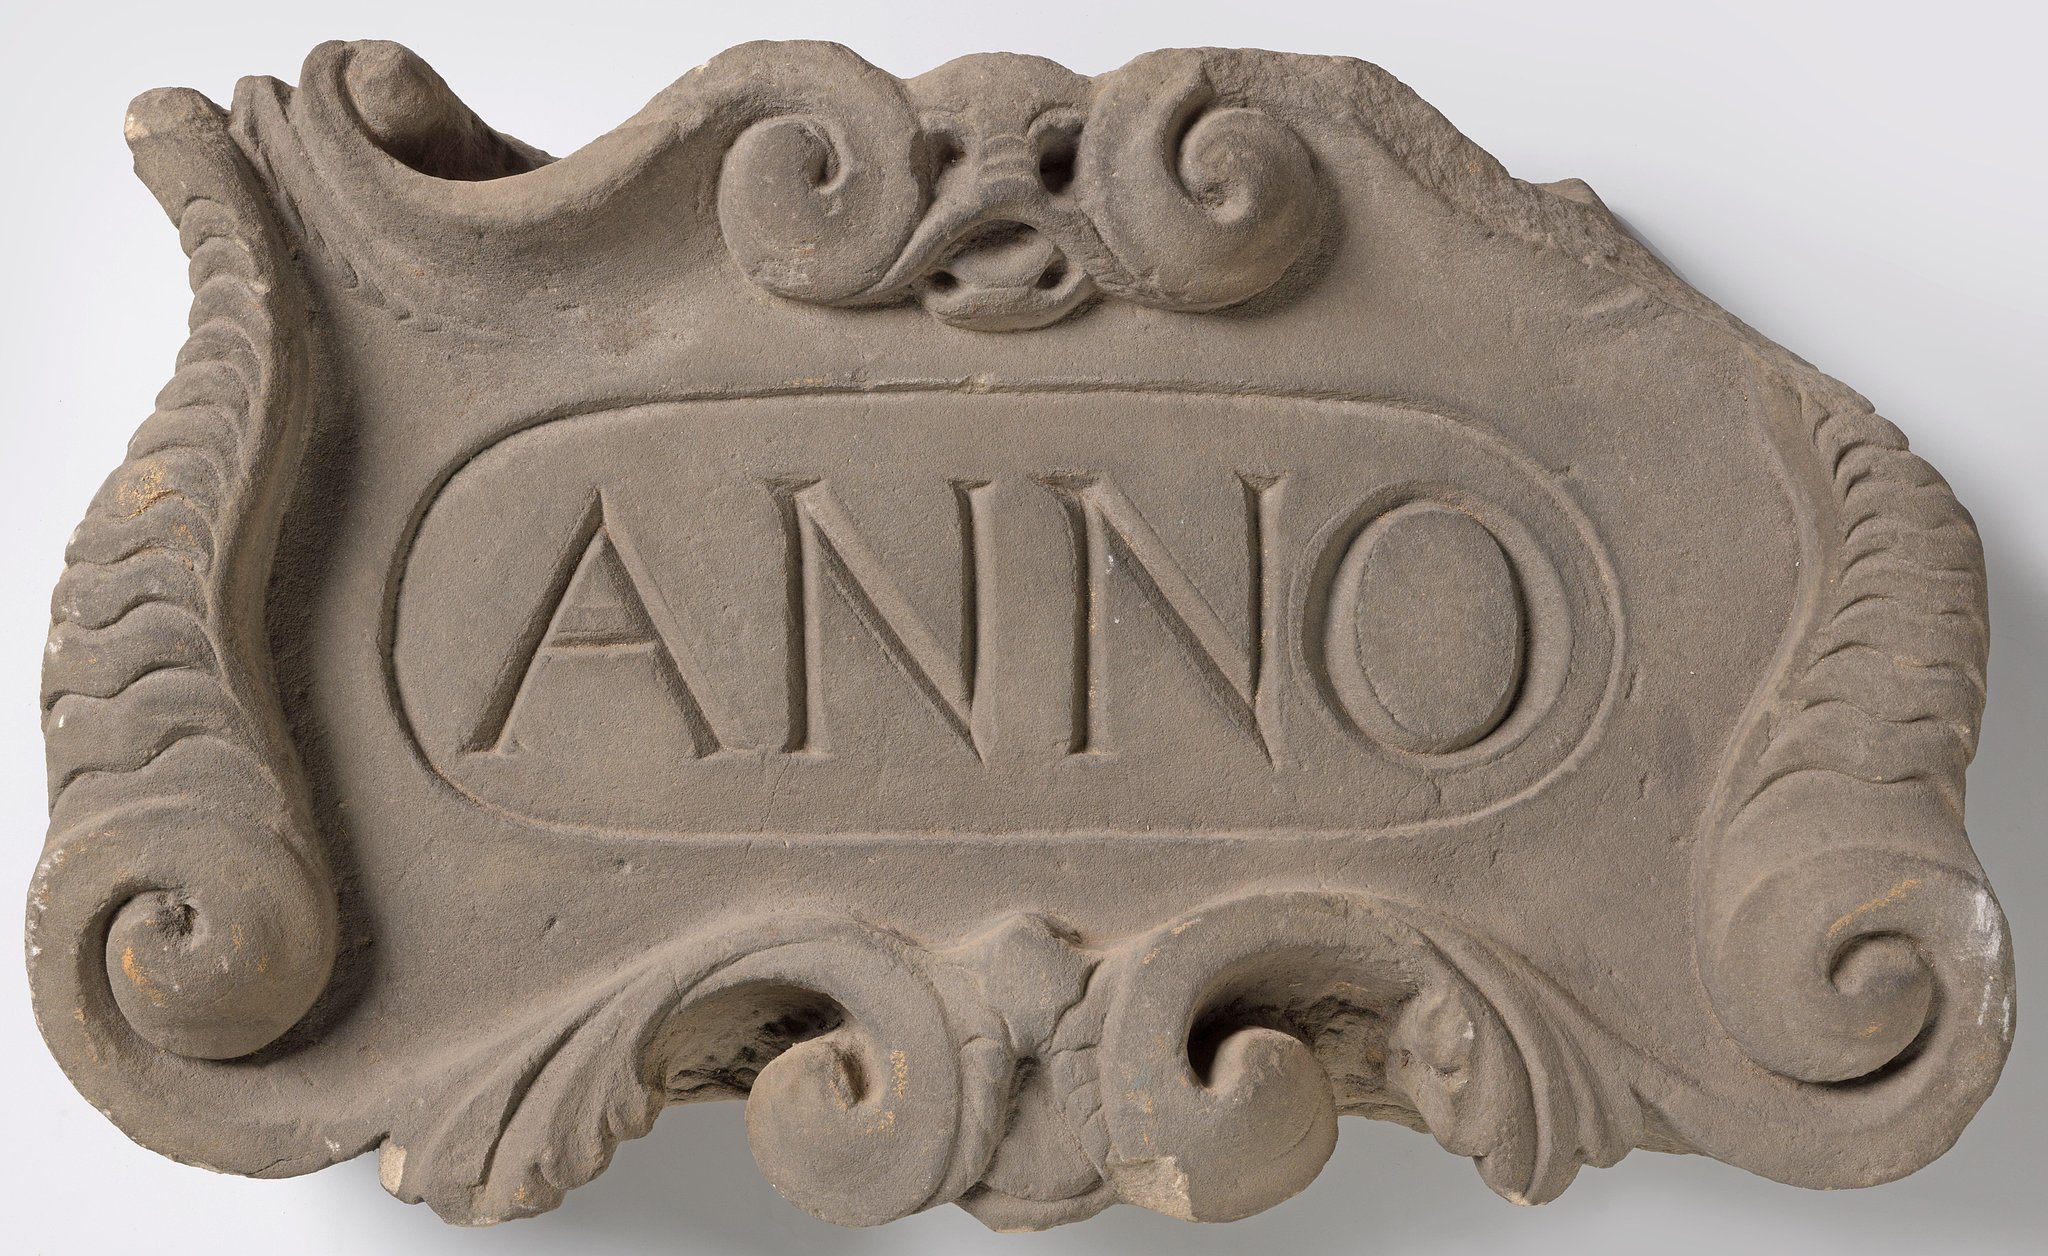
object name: gable stone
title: Gevelsteen met opschrift ANNO.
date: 1736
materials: stone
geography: netherlands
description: Cartouche met krullen, voluten en acanthusbladeren, waarbinnen een ovaal waarbinnen het opschrift ANNO. De rechter bovenhoek is afgebroken. Bij de steen hoort een steen (KOG-ALS-149-1) met D Hollandse Hoedemakerij en een steen (KOG-ALS-149-3) met 1736.